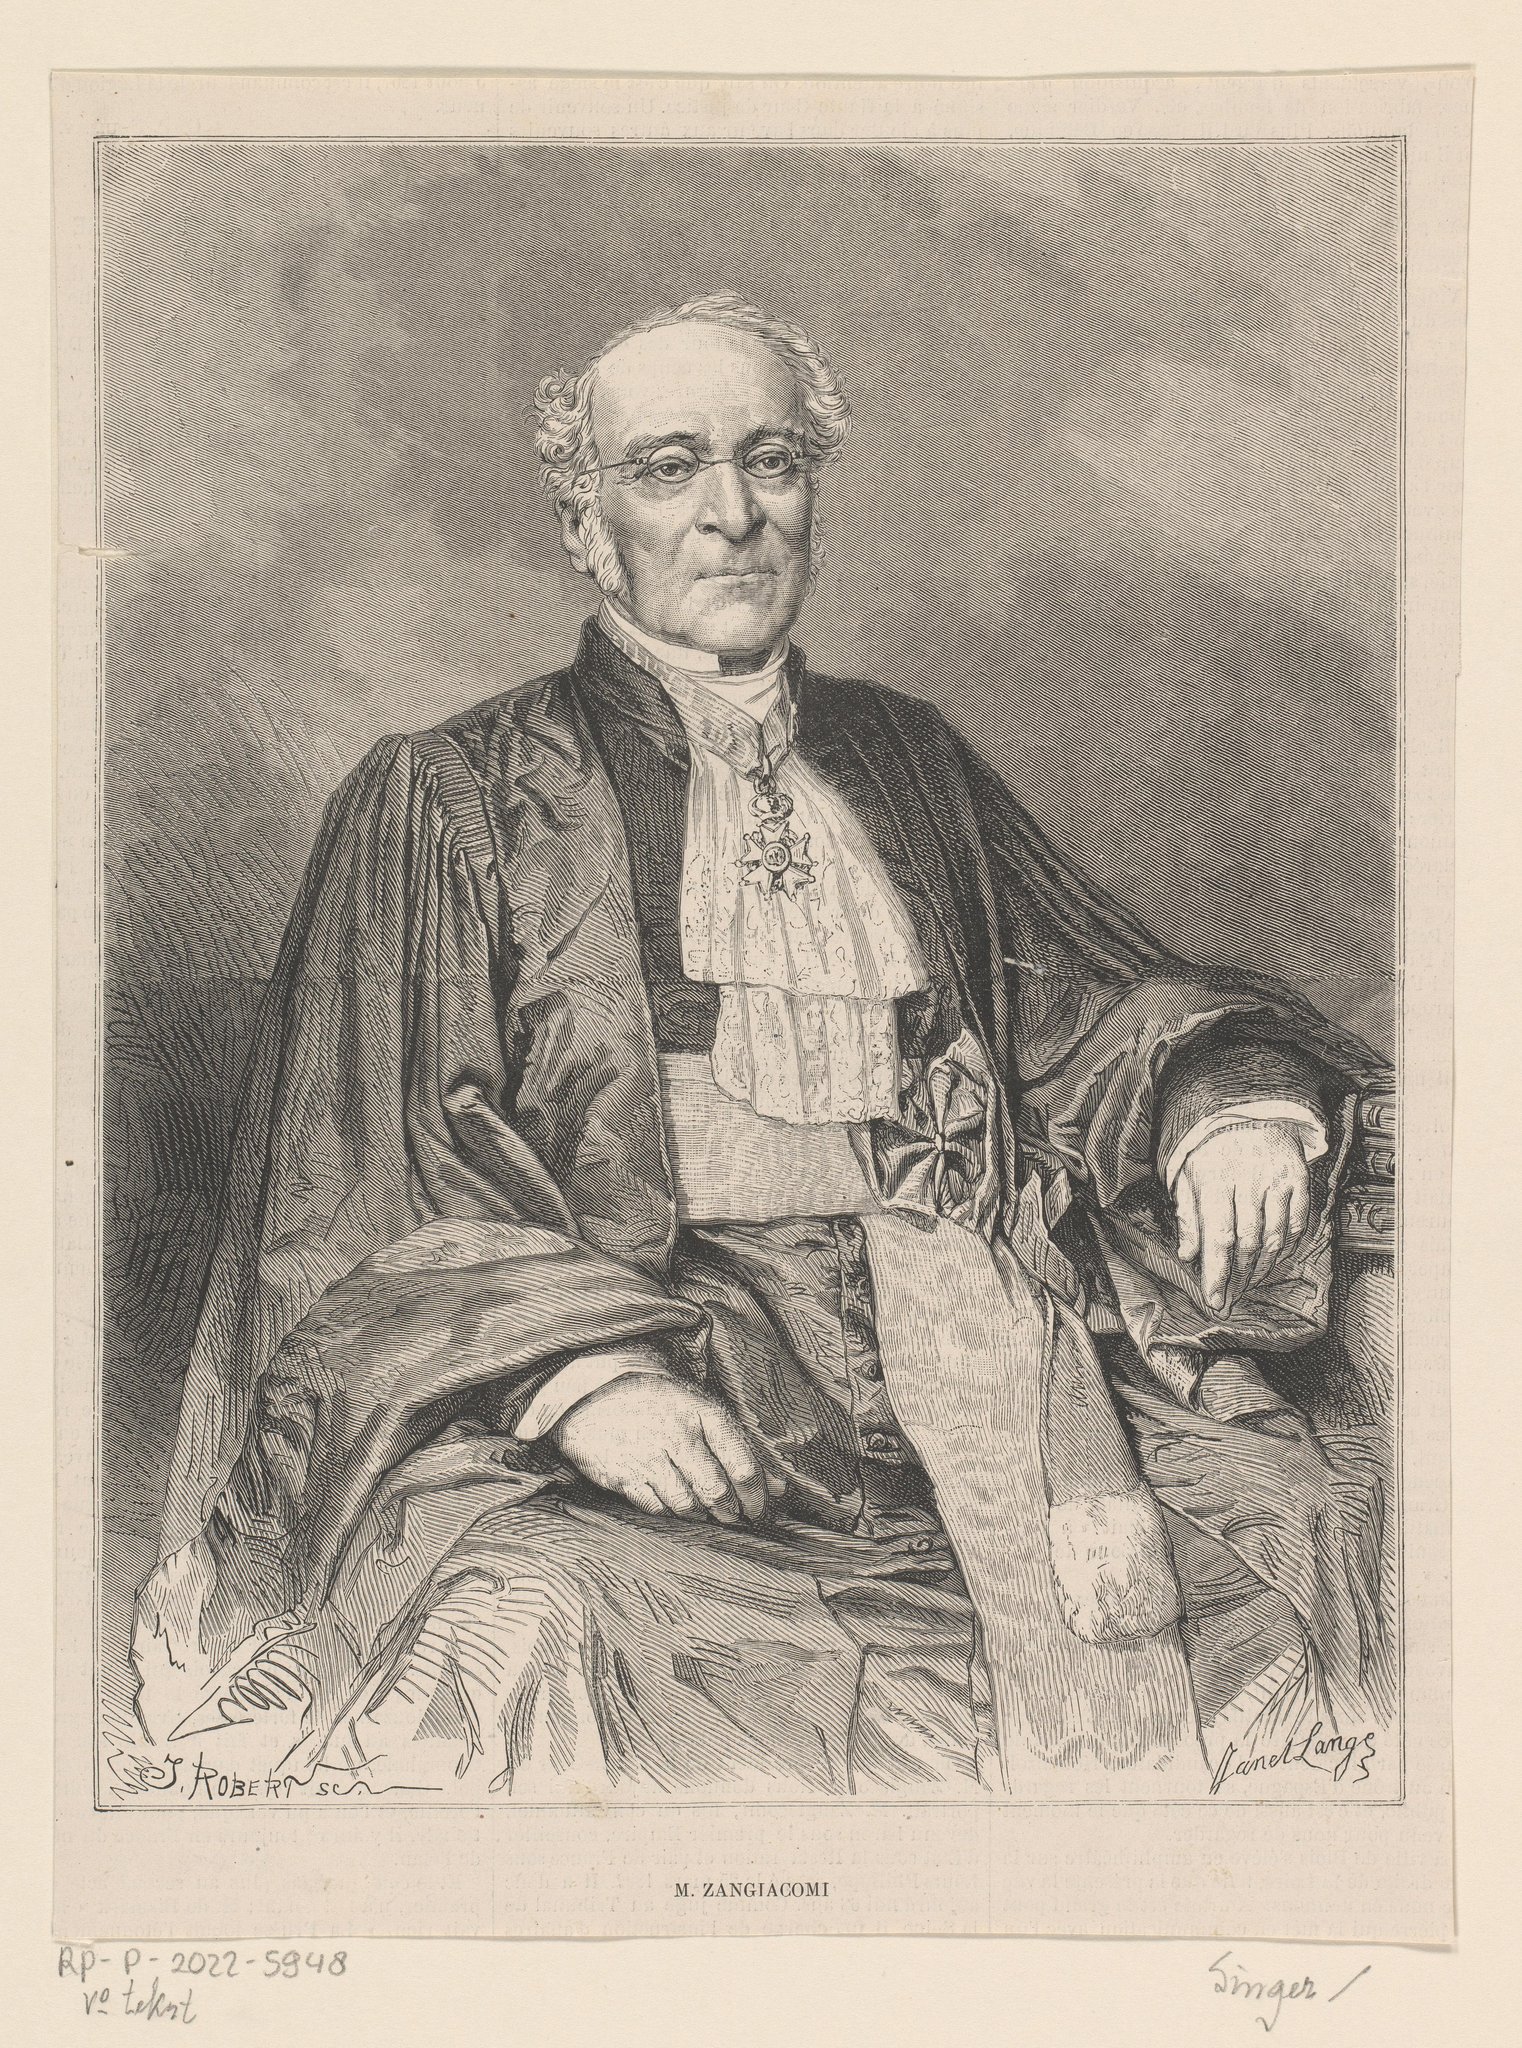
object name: print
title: Portret van Prosper Zangiacomi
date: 1870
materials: paper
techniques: letterpress printing, engraving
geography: paris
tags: paris, historical persons, lawyer, attorney at law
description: Prent uit: L'Illustration 28 (187), nr. 1427, 2 juli 1870, p. 49. 0